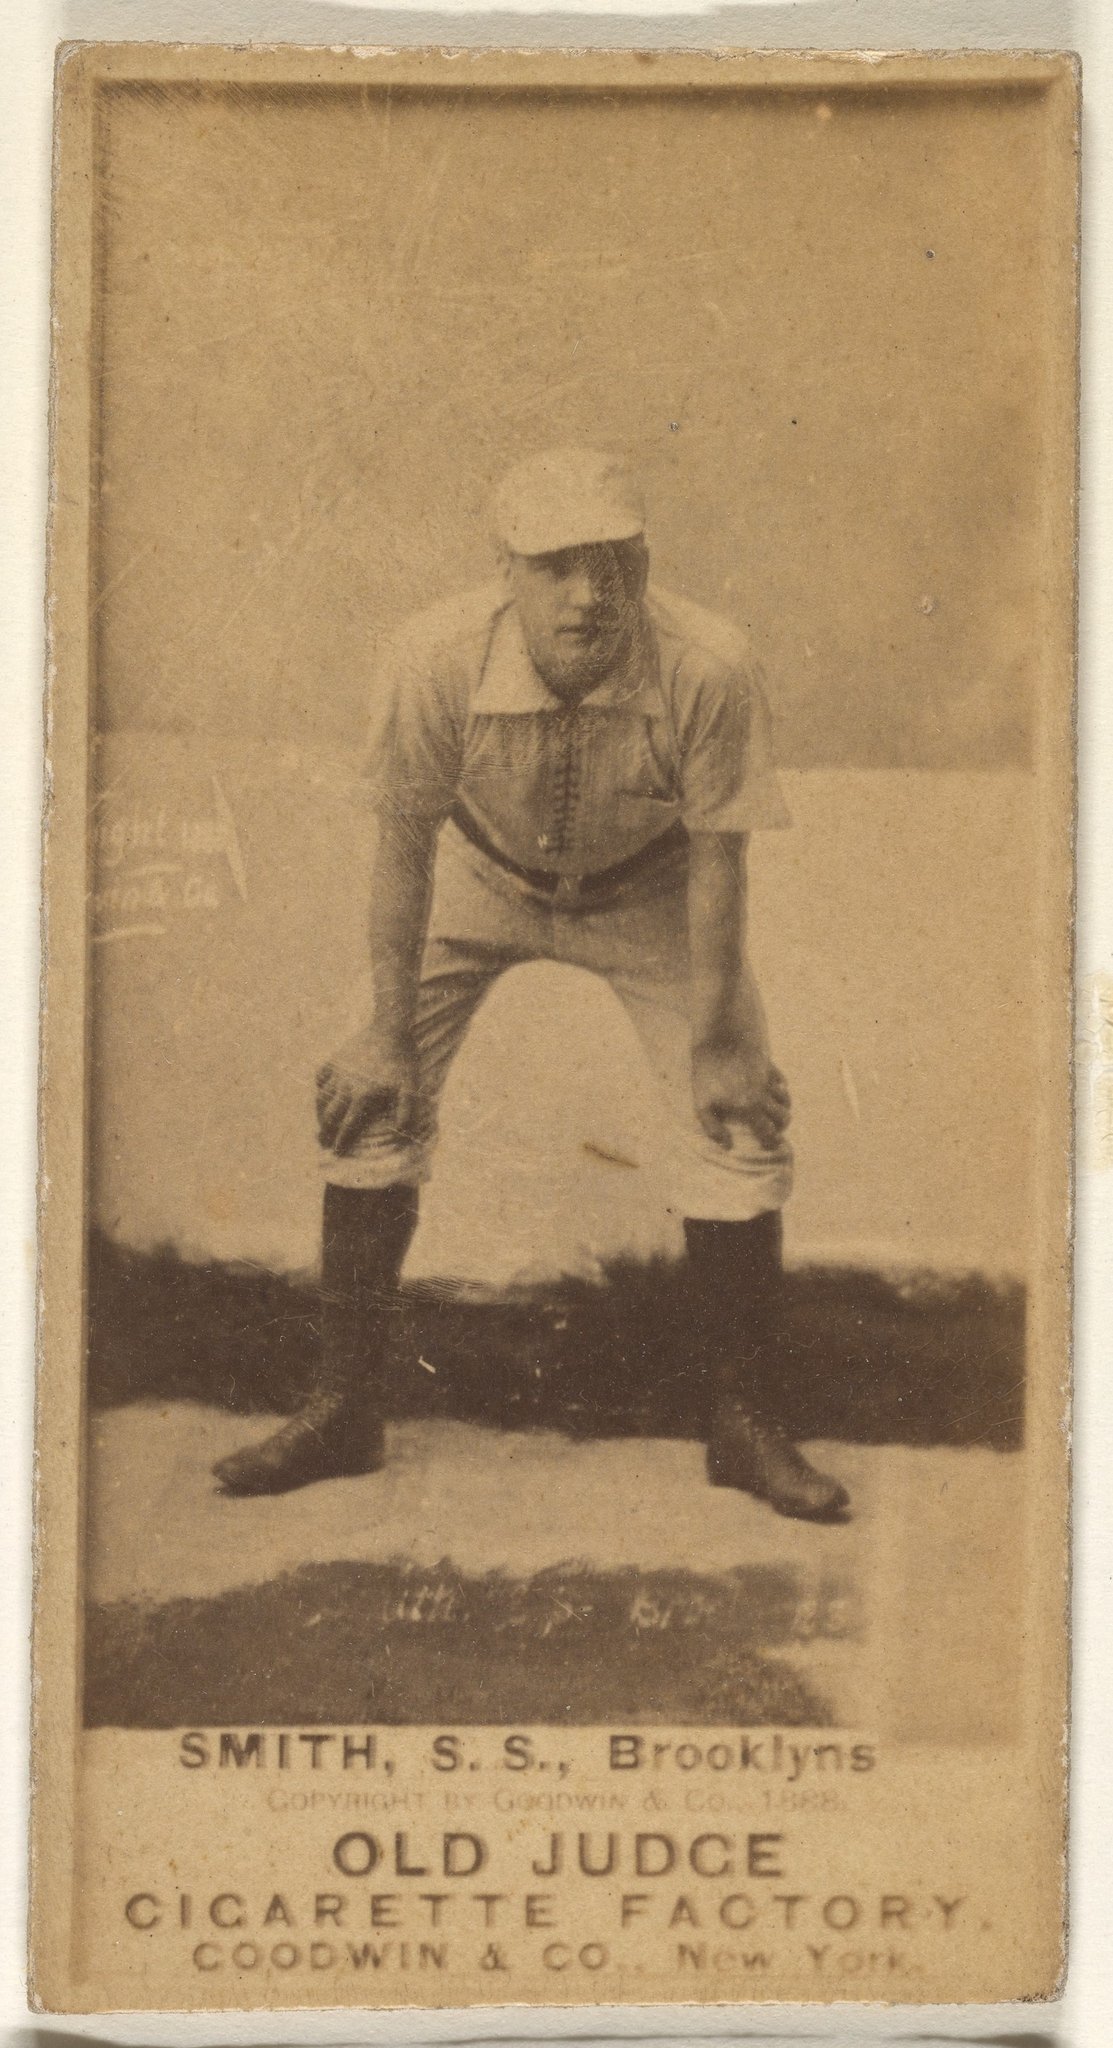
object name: baseball card, photograph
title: Smith, Shortstop, Brooklyn Bridegrooms, from the Old Judge series (N172) for Old Judge Cigarettes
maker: goodwin & company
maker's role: publisher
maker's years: 1850-1950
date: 1888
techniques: albumen silver print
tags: men,portraits,baseball,athletes